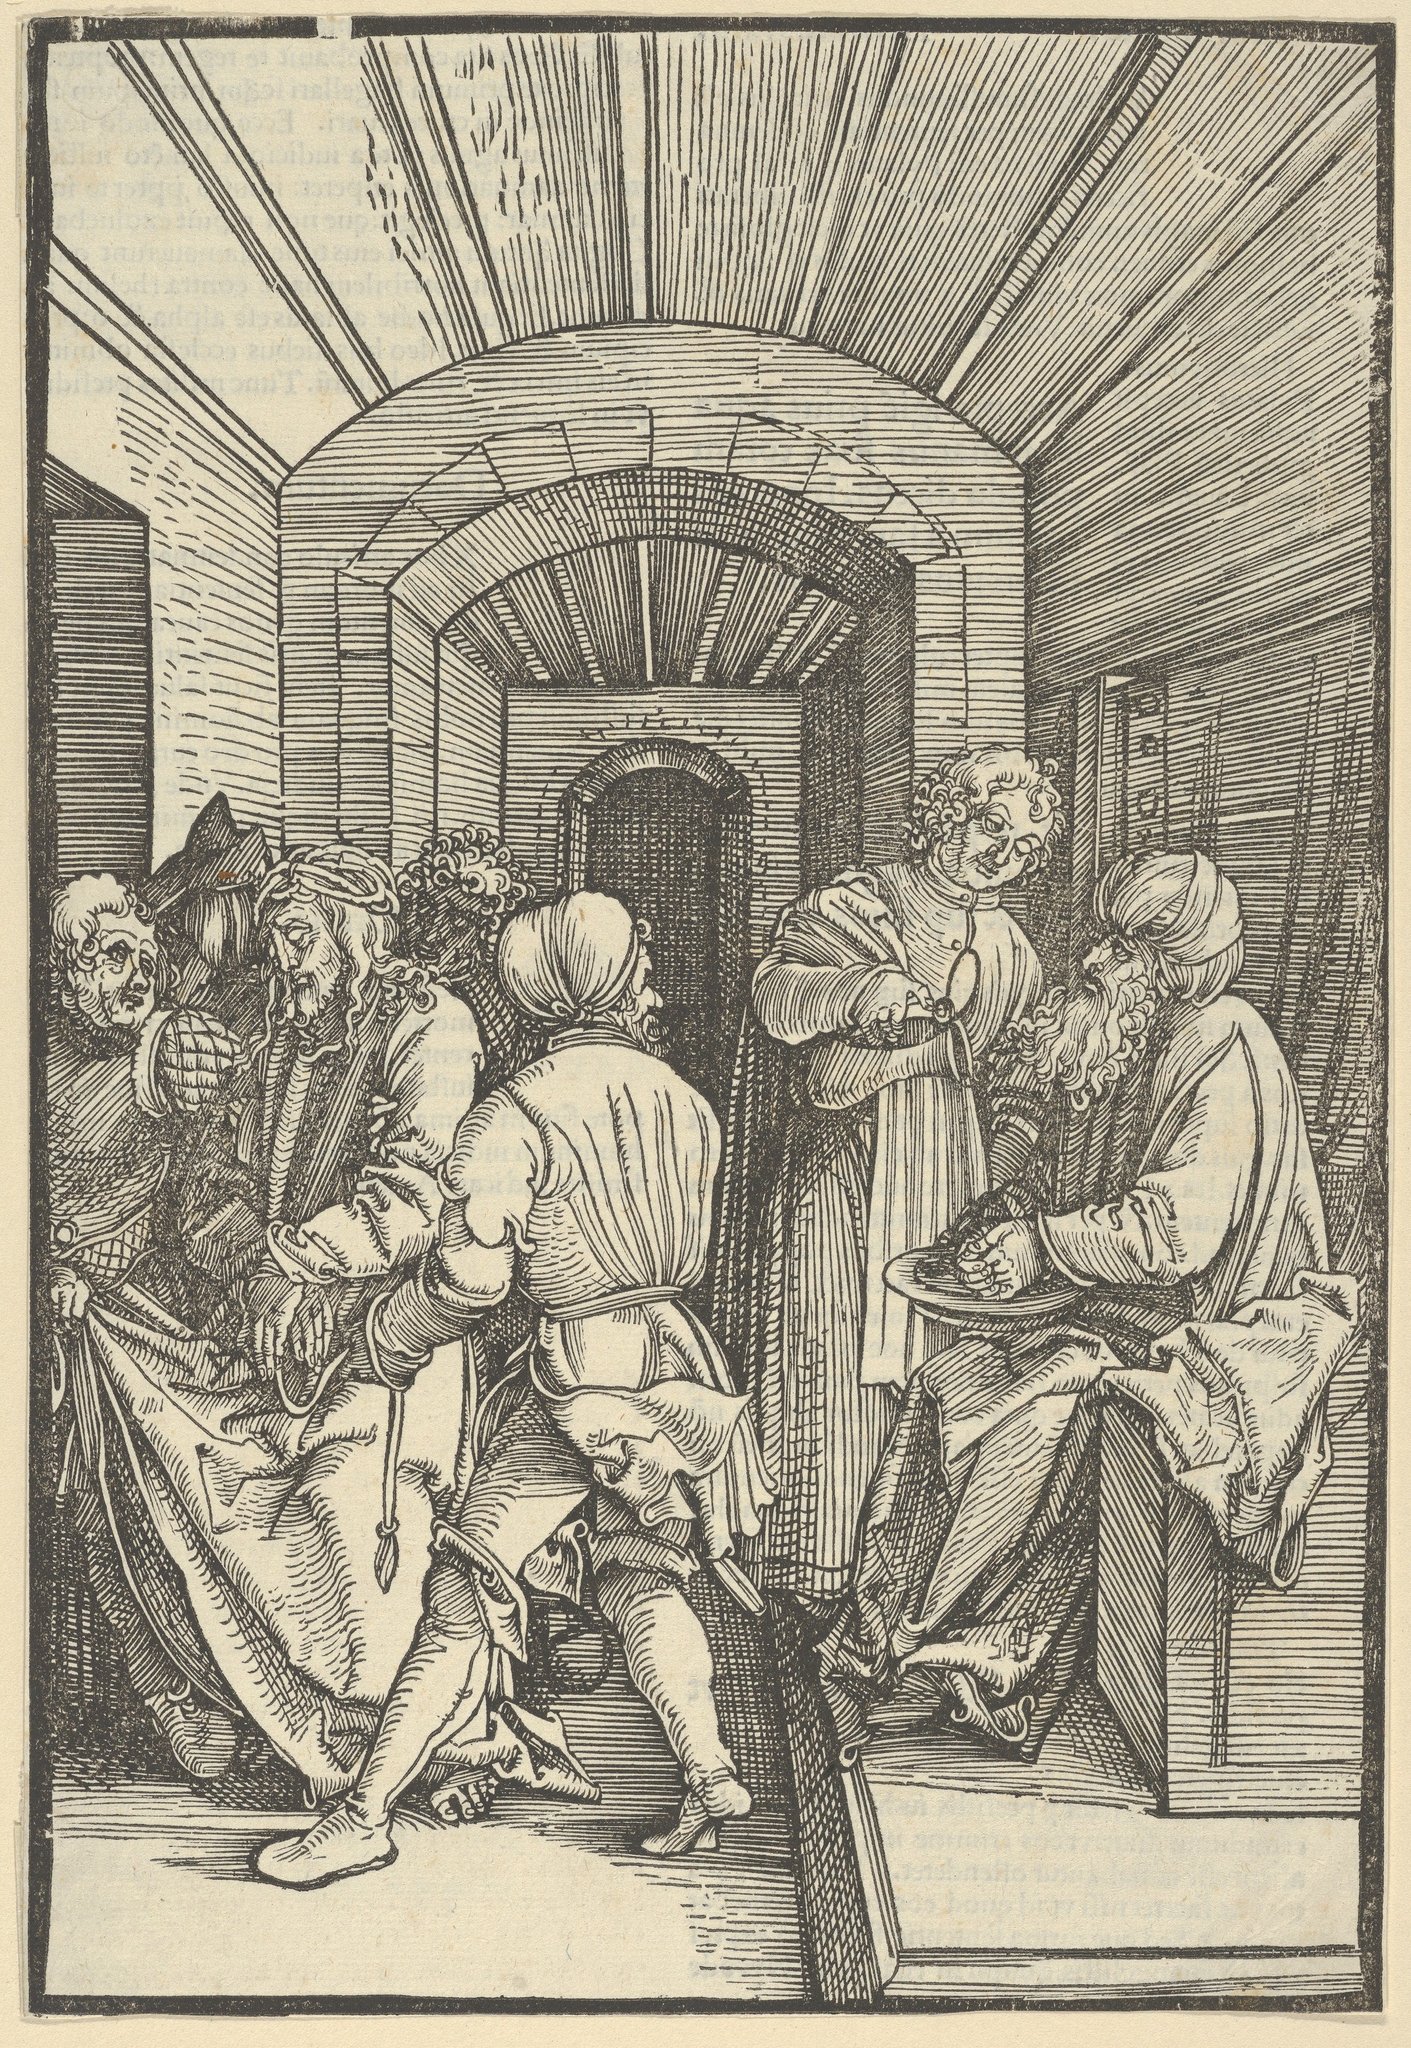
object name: print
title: Pilate Washing his Hands, from Speculum passionis domini nostri Ihesu Christi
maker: hans schäufelein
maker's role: artist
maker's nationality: german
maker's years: 1480-1540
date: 1507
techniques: woodcut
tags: men,christ,washing,pilate